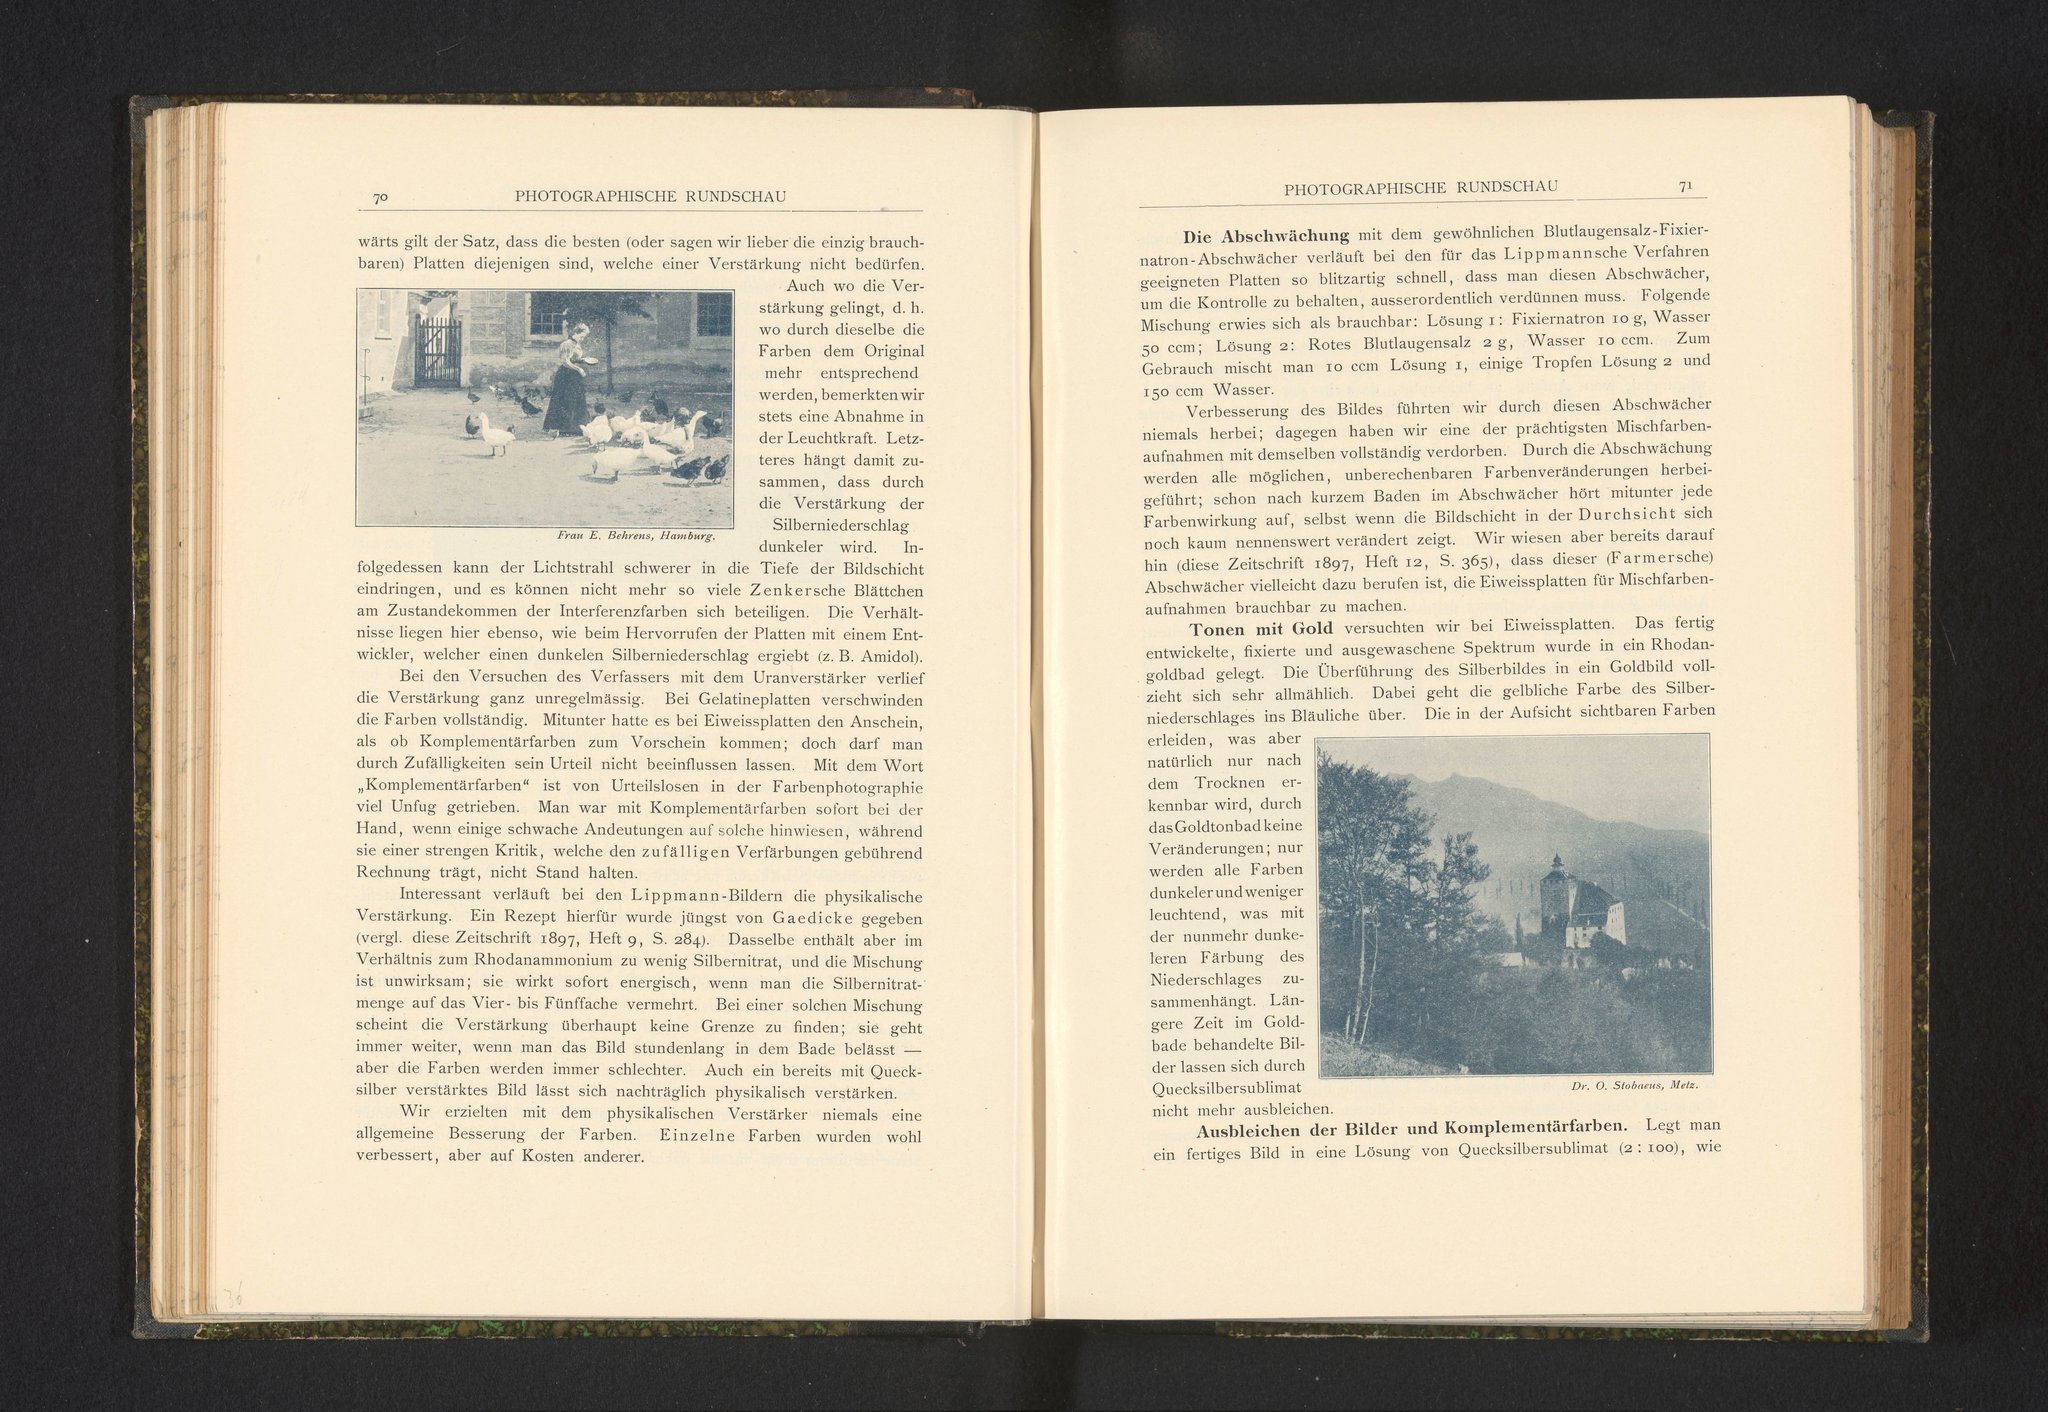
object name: page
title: Vrouw voert ganzen en kippen op een binnenplaats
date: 1893-1898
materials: paper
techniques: autotype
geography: hamburg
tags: adult woman, poultry farm, feeding wild animals